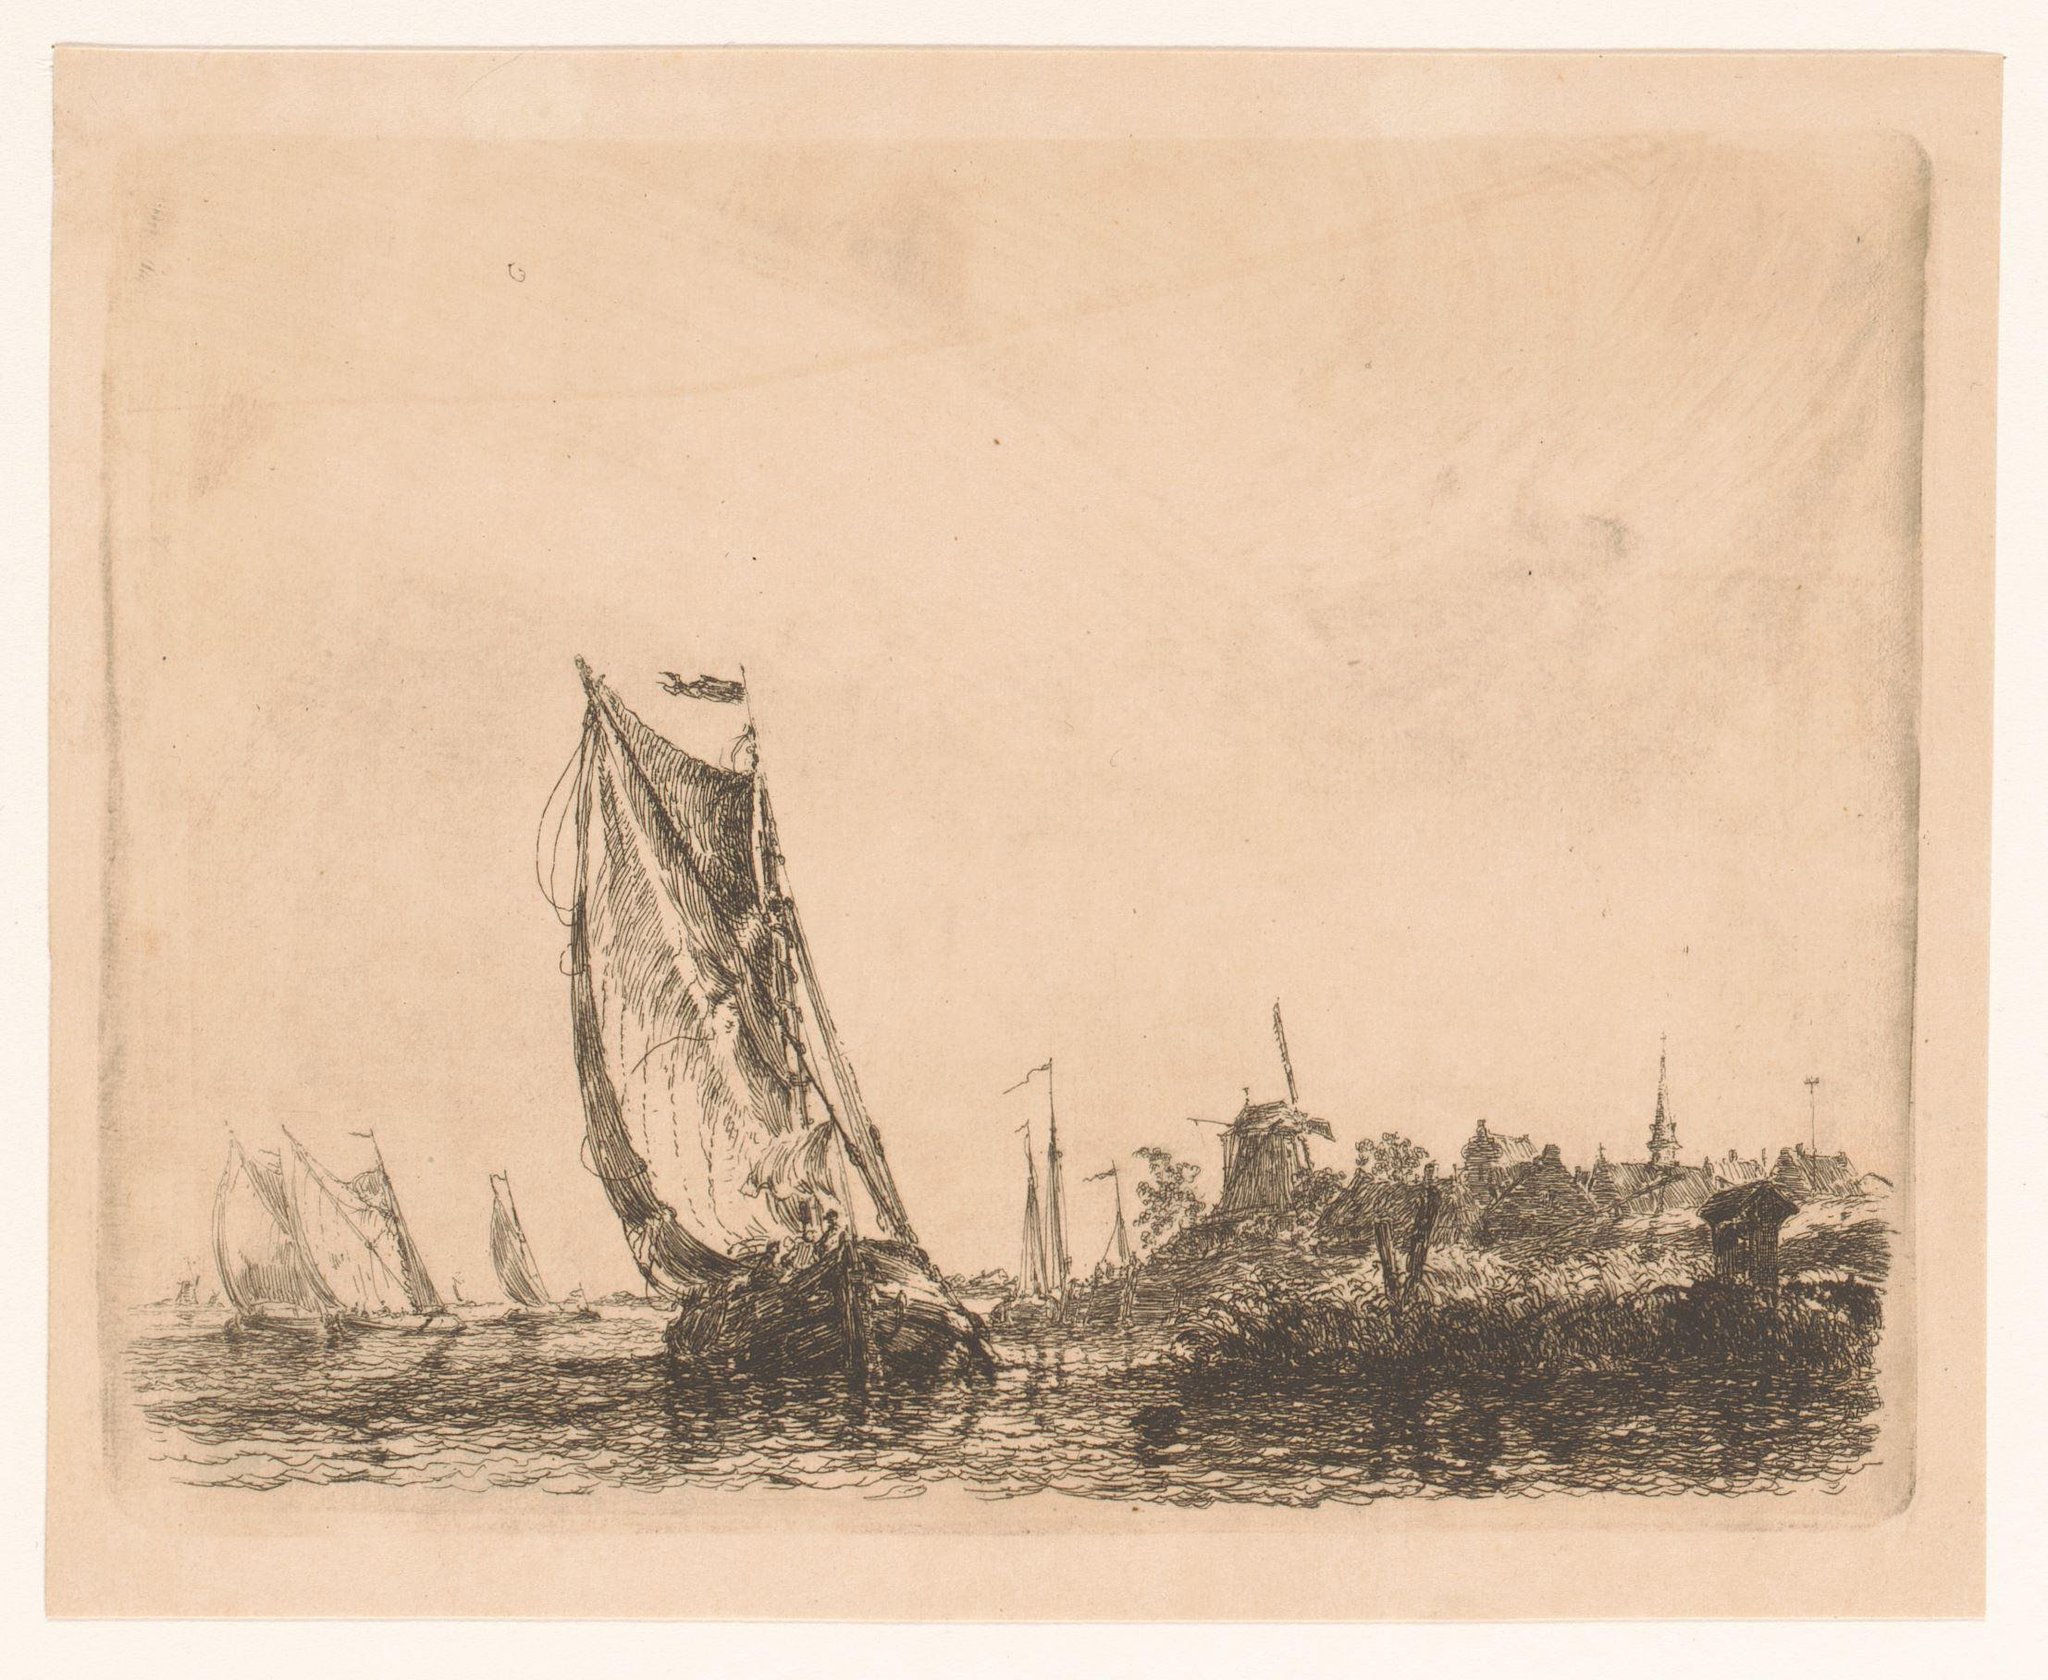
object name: print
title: Boten op de Schelde met rechts een dorp met molen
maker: henri françois schaefels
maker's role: print maker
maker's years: 1827-1904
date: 1853-1860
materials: paper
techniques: etching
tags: sailing-ship, sailing-boat, landscapes with waters, waterscapes, seascapes (in the temperate zone), village, windmill in landscape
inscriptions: collector's mark: Lugt 2228, collector's mark: Lugt 1485